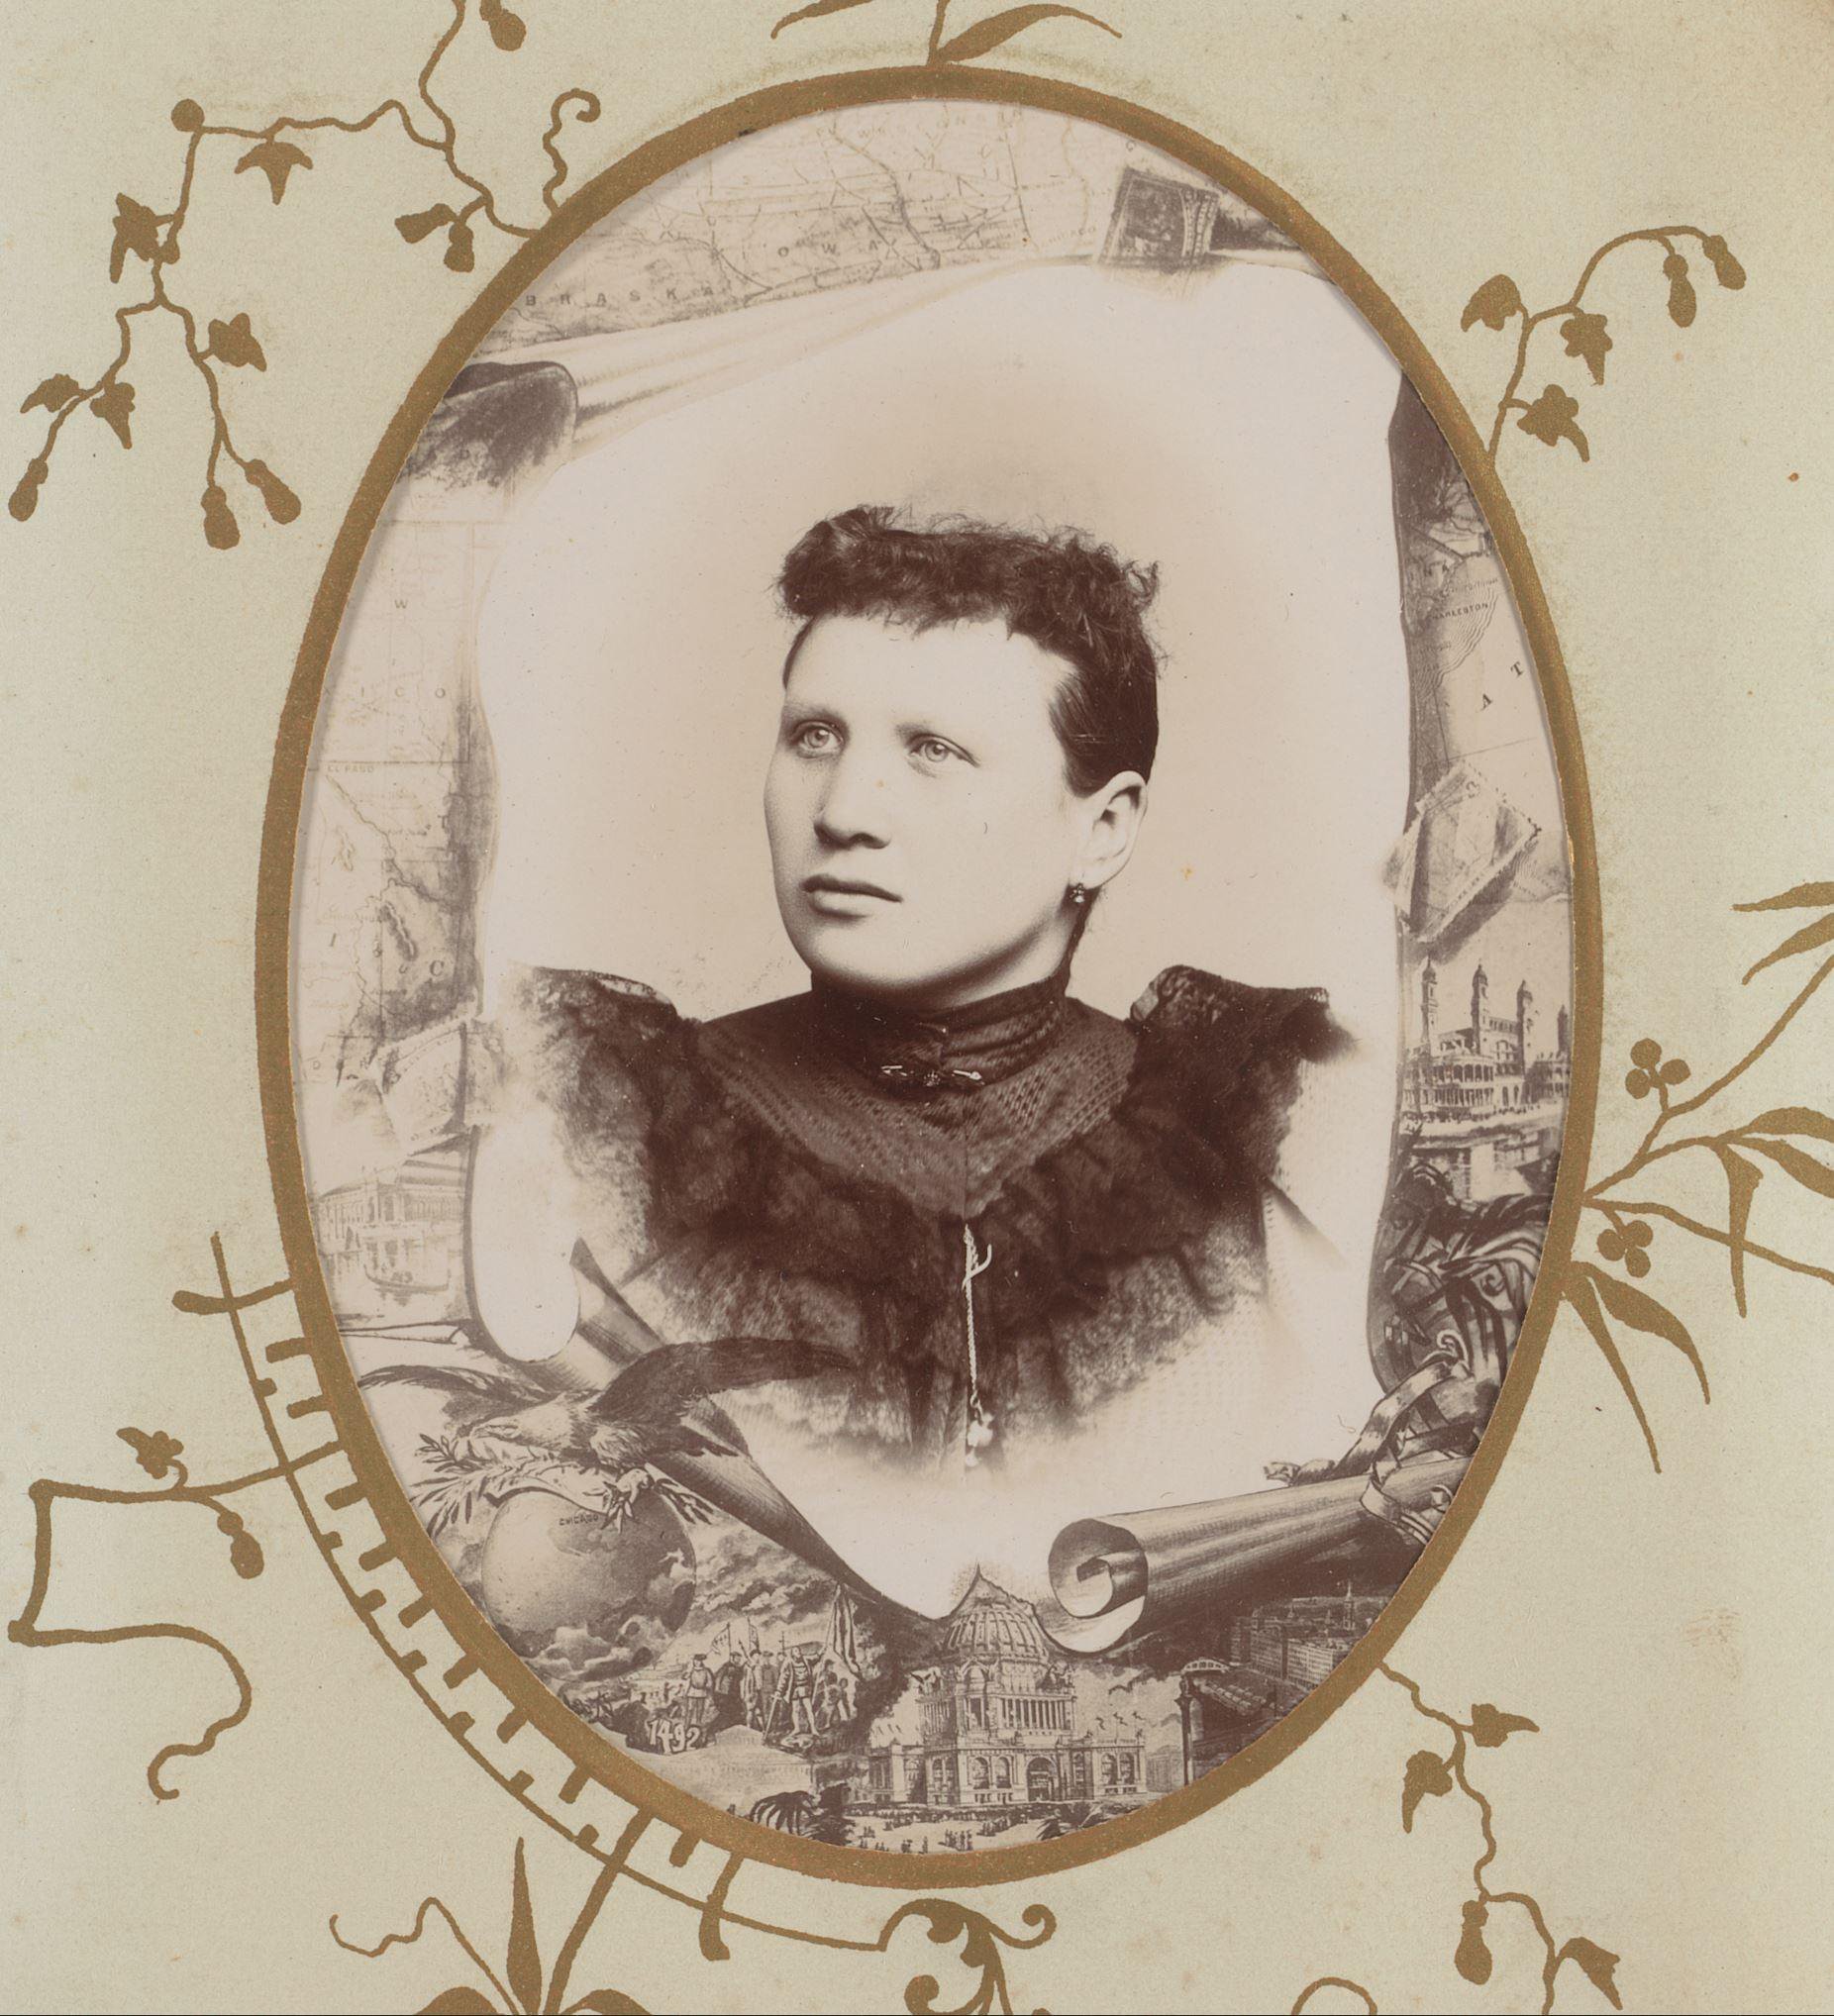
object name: album leaf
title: Portret van een vrouw met gedecoreerde omlijsting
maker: hoffmeister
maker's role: fotograaf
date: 1860-1900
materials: cardboard, photographic support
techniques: collodion silver print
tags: adult woman, 'passe-partout', historical persons